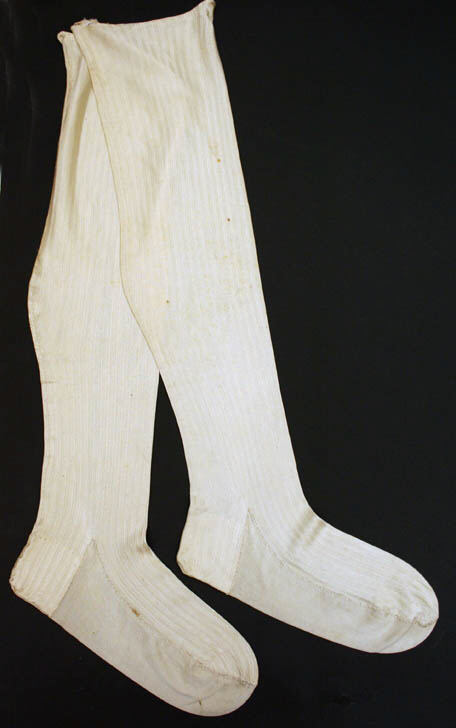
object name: stocking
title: Stockings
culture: british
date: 1800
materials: silk